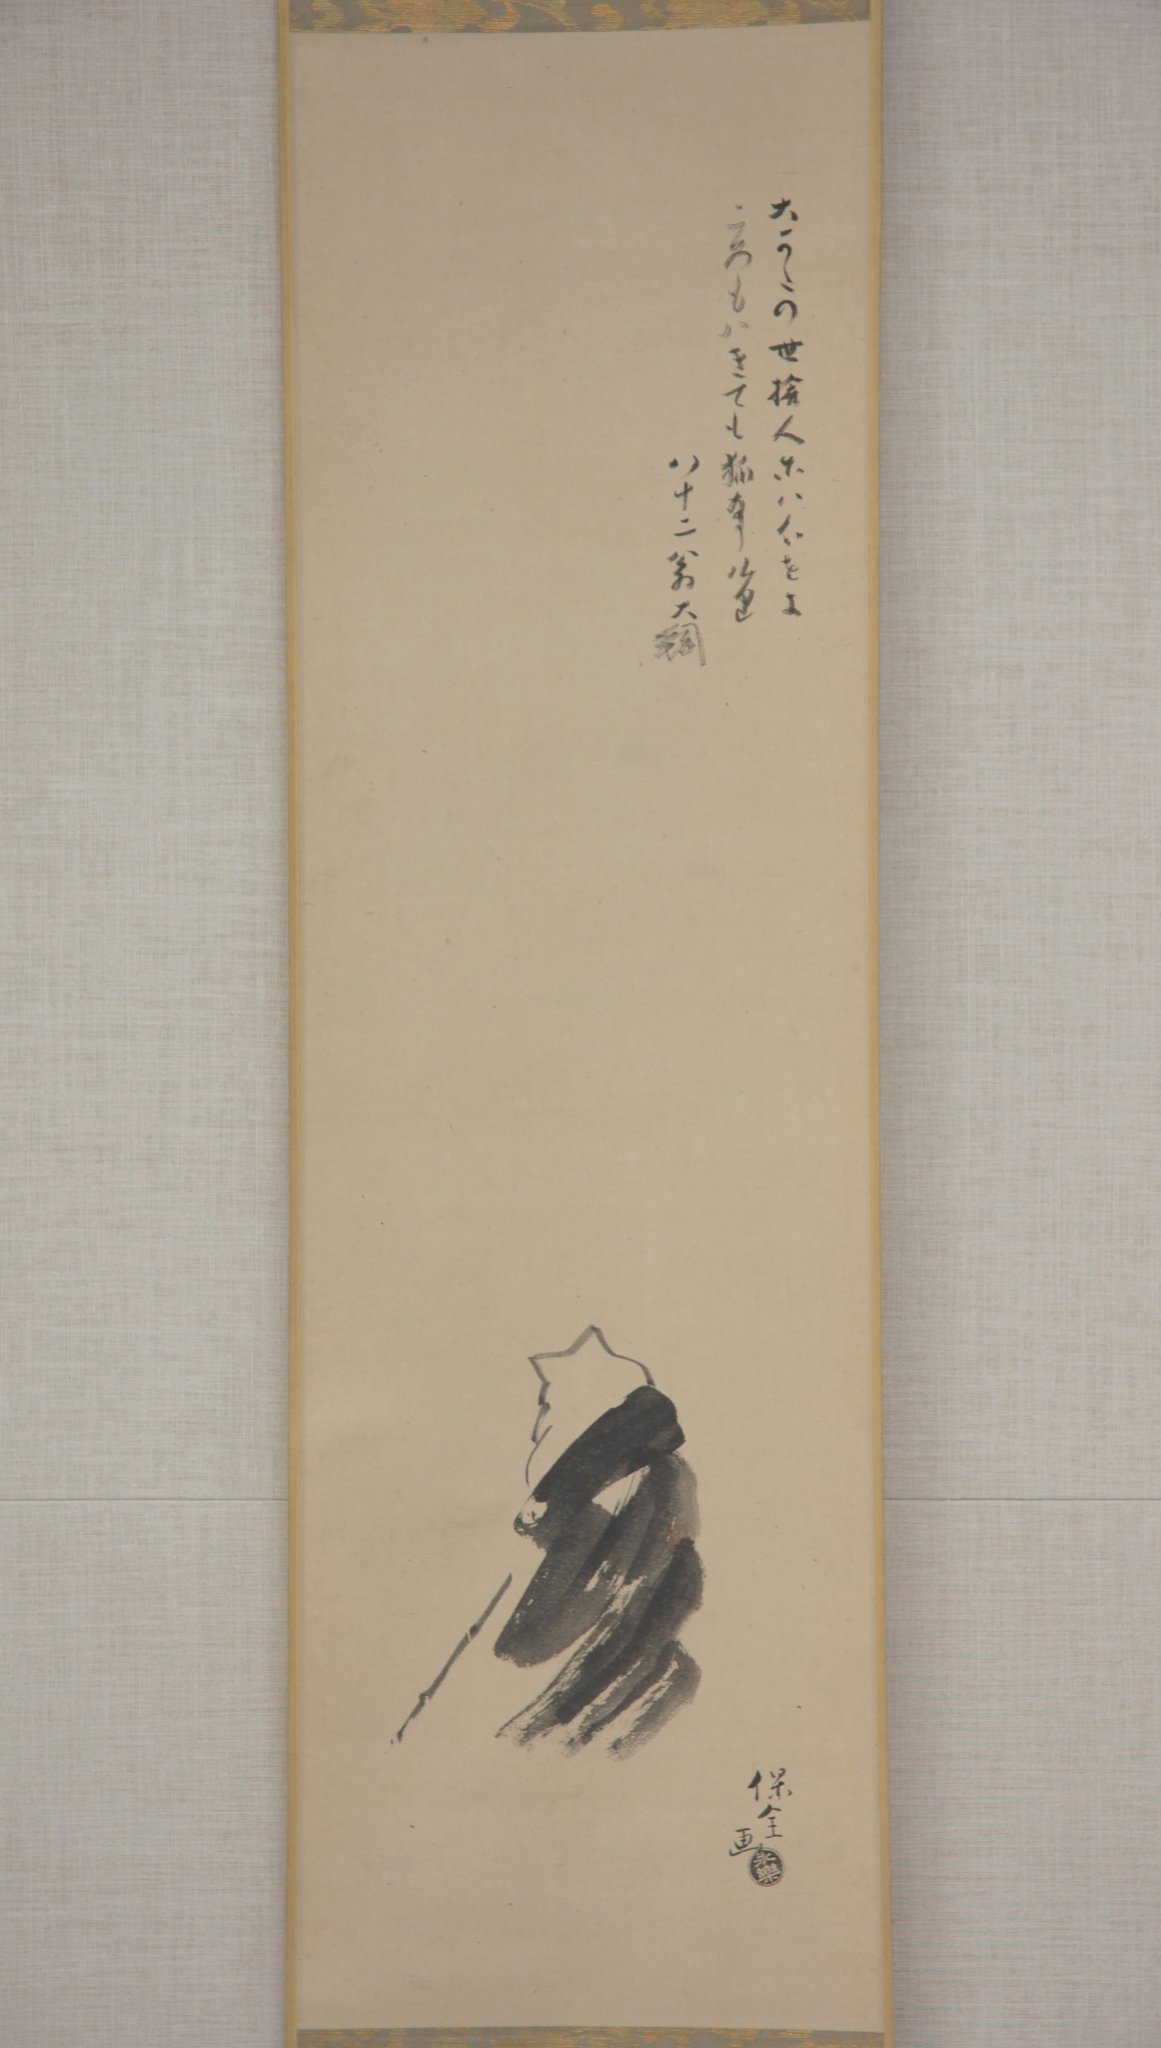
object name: hanging scroll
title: Fox with Staff (Hakuzōsu)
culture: japanese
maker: eiraku hozen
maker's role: artist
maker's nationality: japanese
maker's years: 1795-1854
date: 1848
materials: ink, paper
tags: foxes